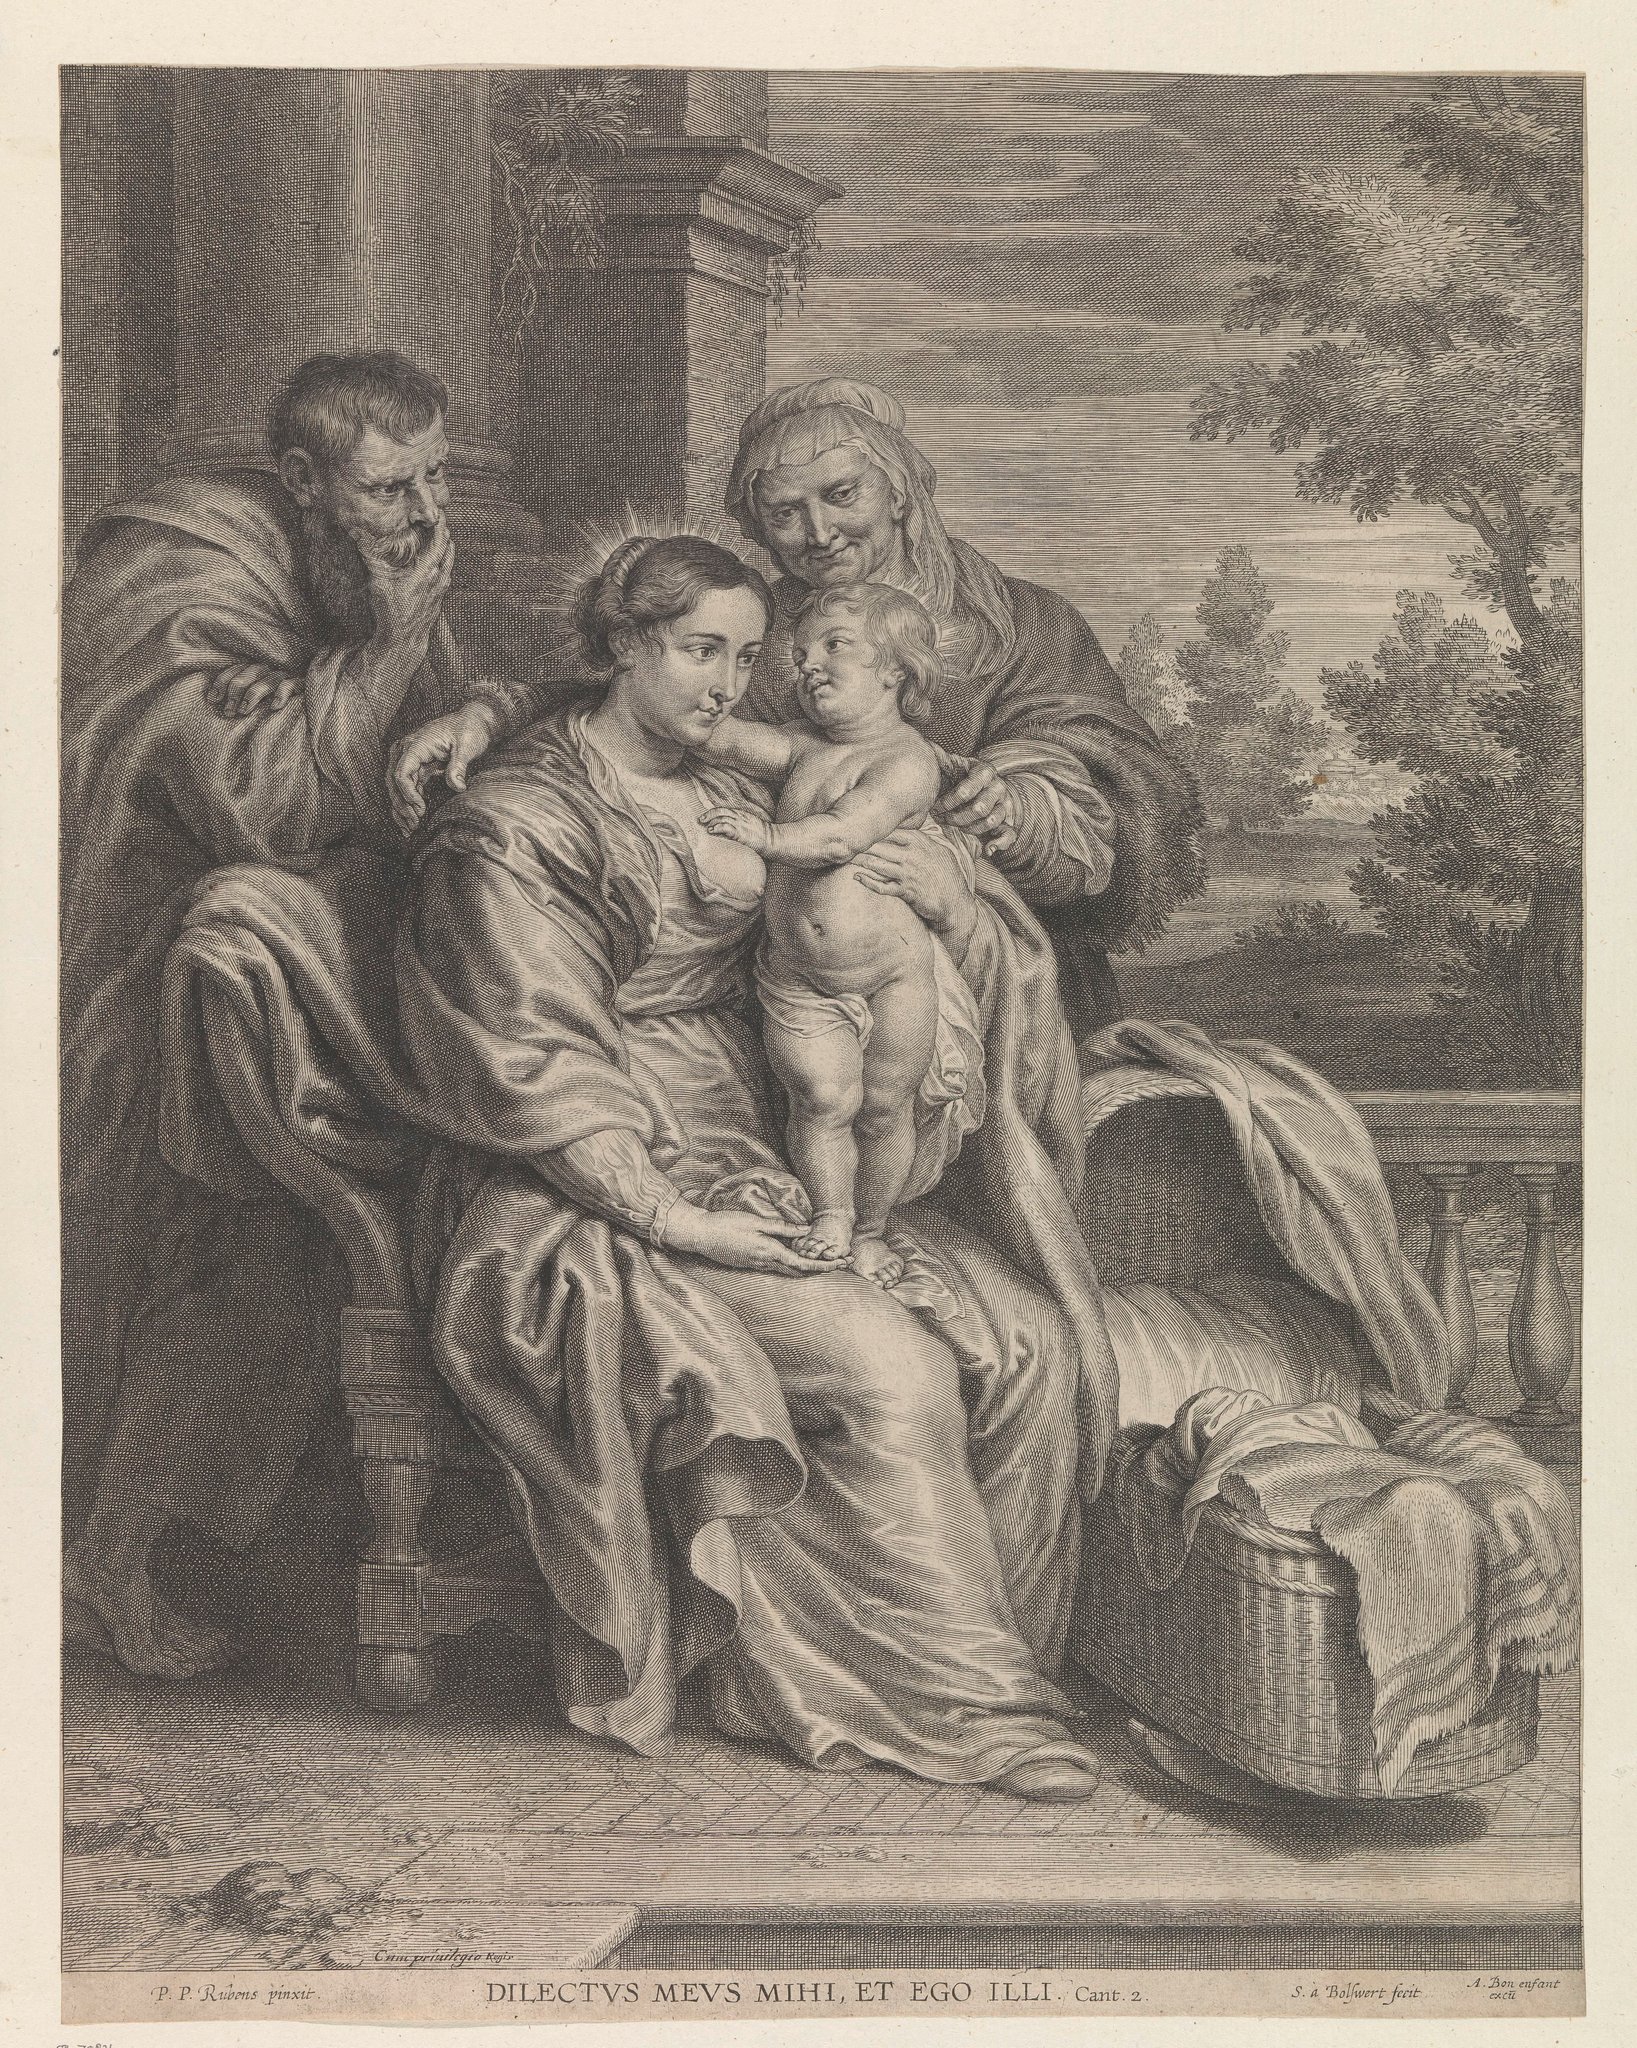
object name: print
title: Heilige Familie met H. Anna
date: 1596-1659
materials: paper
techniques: engraving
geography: southern netherlands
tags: holy family, and derived representations, anna, mother of mary; possible attributes: book, christ-child, lily, virgin mary, cradle, crib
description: Maria zit met het Christuskind staand op haar schoot en zij heeft een borst ontbloot. Naast haar staat een wieg. Jozef en Anna kijken liefdevol naar het kind. Onder de voorstelling staat een bijbeltekst uit Hoogl. 2:16. Deze prent maakt deel uit van een album.